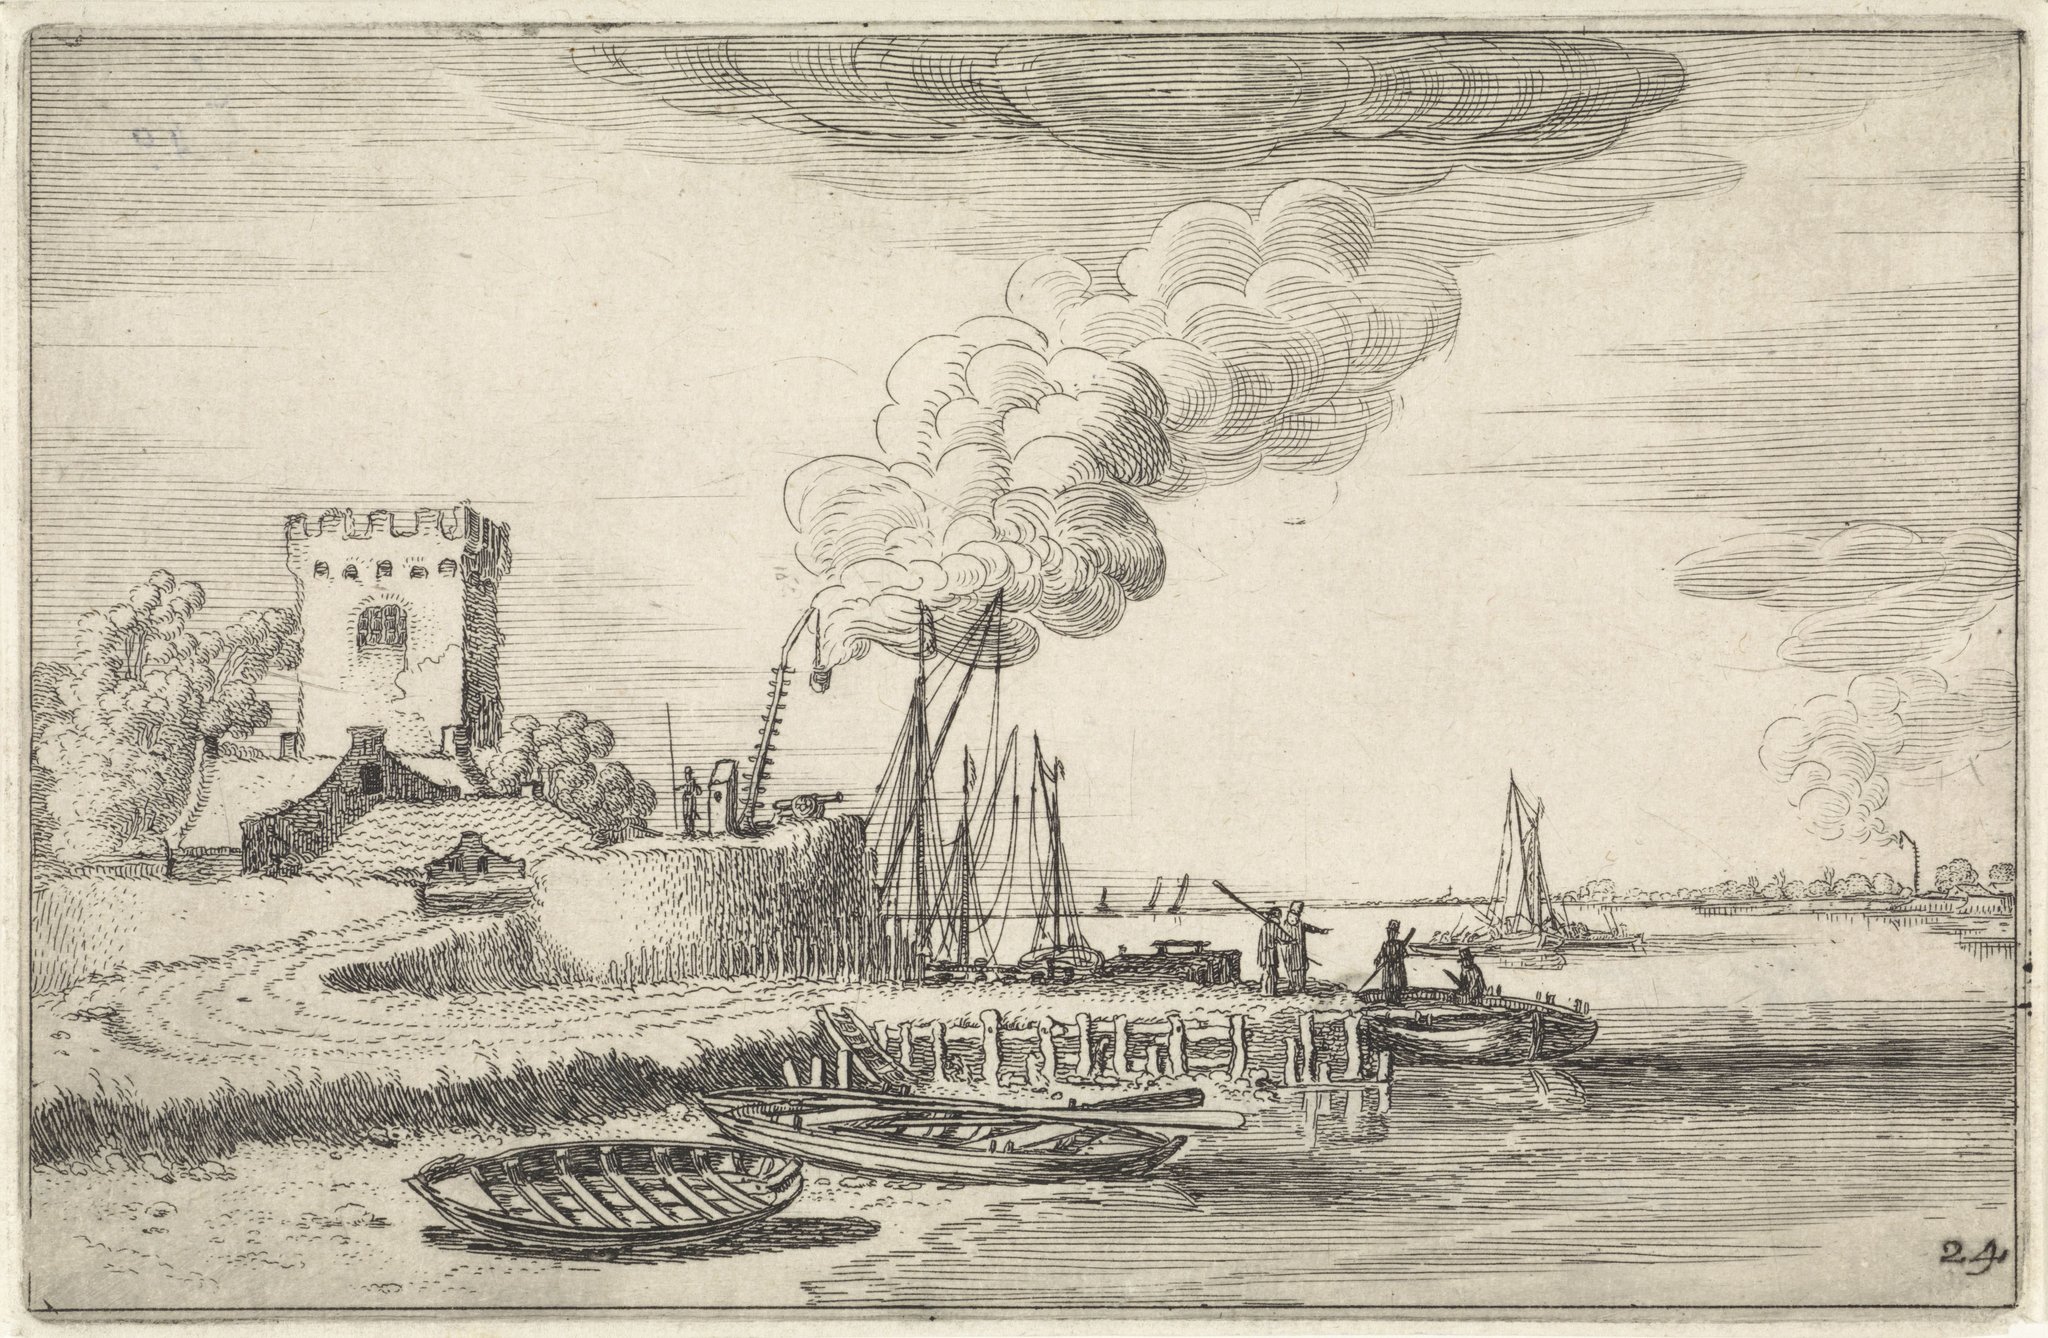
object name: print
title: Amenissimae aliquot requculae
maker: jan van de velde (ii)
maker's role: draughtsman, painter, print maker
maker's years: 1593-1641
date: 1616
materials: paper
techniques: etching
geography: northern netherlands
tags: harbour, smoke-stack, landscape with tower or castle, beacon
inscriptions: collector's mark: Lugt 964, number: ‘49’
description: Landschap met een vuurtoren in een haven. Een rookpluim stijgt op. Rechts aan de overzijde, aan de horizon, een tweede brandende vuurtoren. Vierentwintigste prent van een serie van in totaal 52 prenten met landschappen, verdeeld over twee delen van elk 26 prenten.